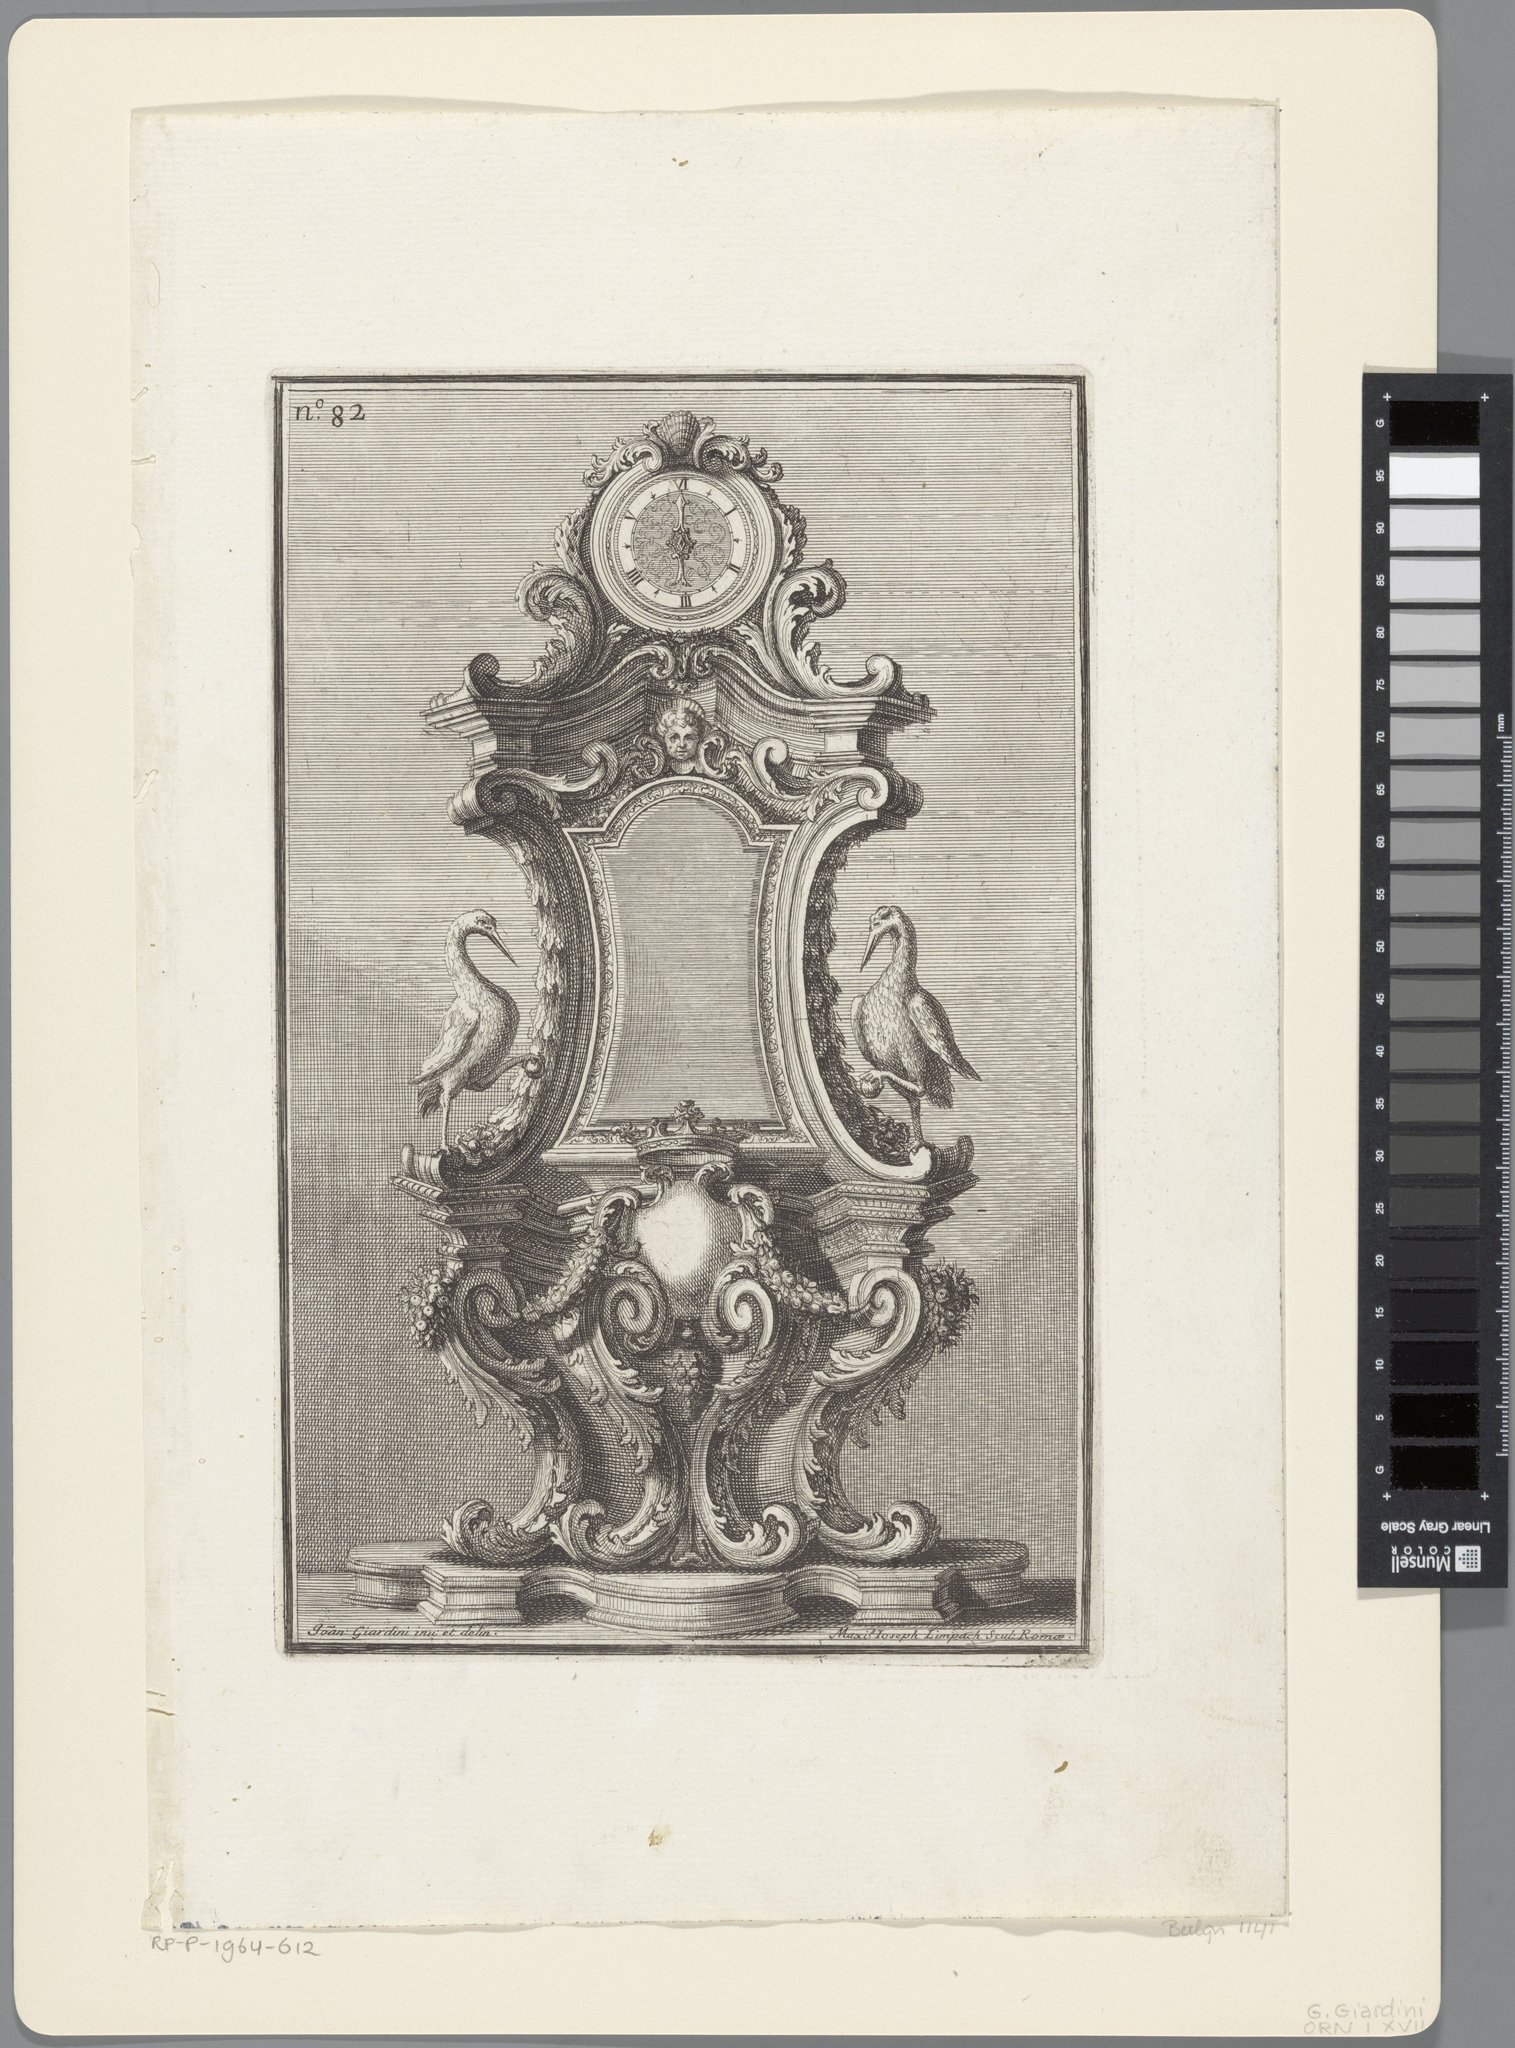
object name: print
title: Disegni diversi inventati e delineati da Giovanni Giardini da Forlì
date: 1714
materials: paper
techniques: etching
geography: rome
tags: shore-birds and wading-birds: stork, clock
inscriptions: collector's mark: Lugt 2228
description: Prent maakt deel uit van een reeks van 100 ornamentprenten naar ontwerp van Giovanni Giardini.